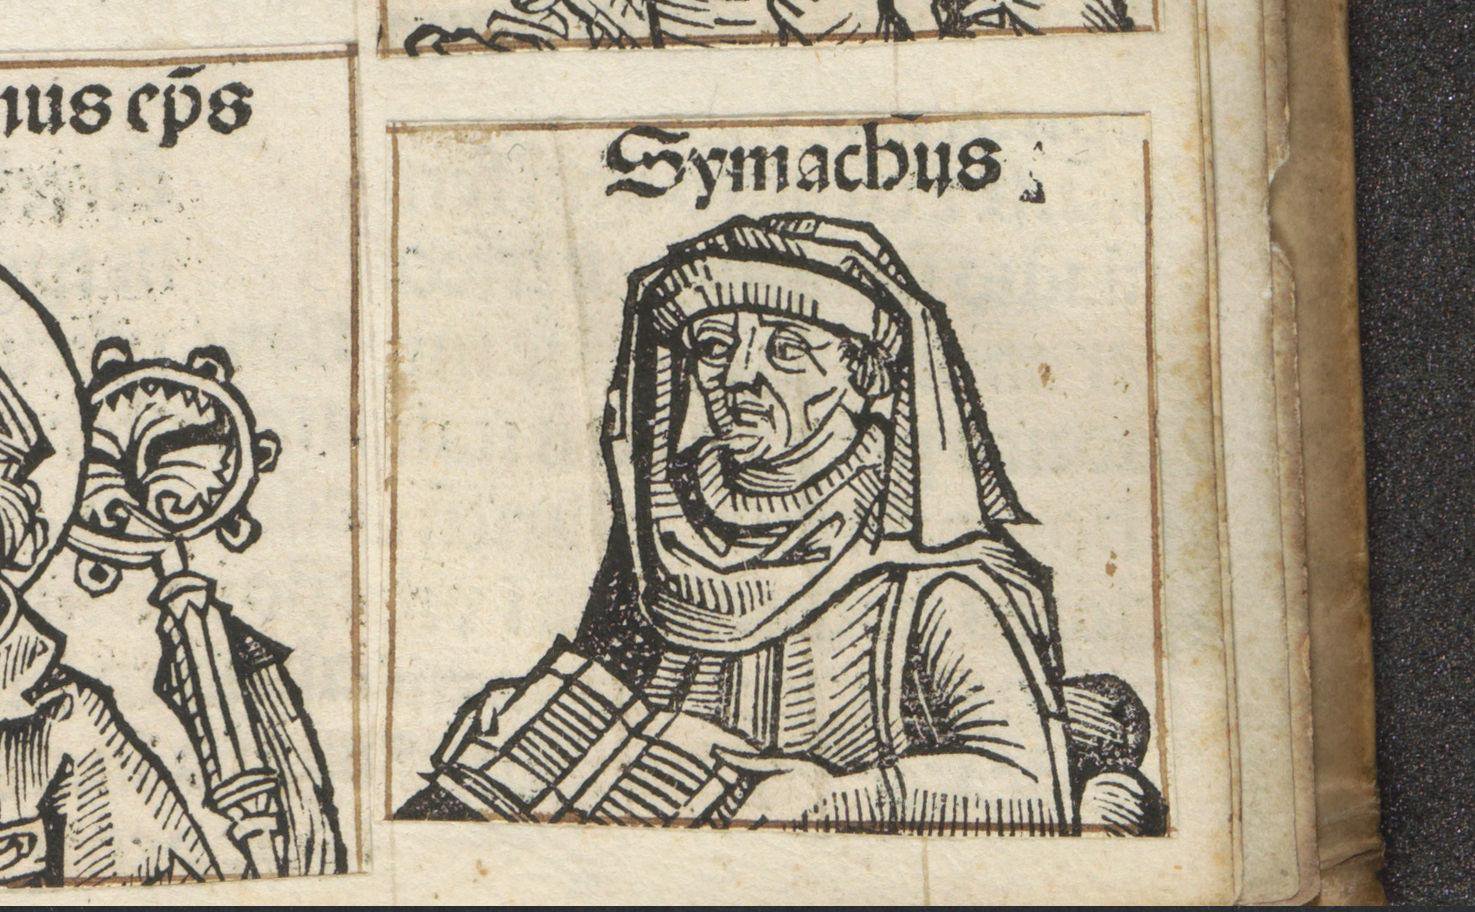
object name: print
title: Liber Chronicarum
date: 1493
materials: paper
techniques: letterpress printing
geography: nuremberg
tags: reading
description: De houtsnede wordt herhaaldelijk gebruikt als boekillustratie in de Liber Chronicarum (of Neurenbergkroniek) van Hartmann Schedel, verschenen in het Latijn en Duits in 1493. Zie de Latijnse uitgave, folio 141v.